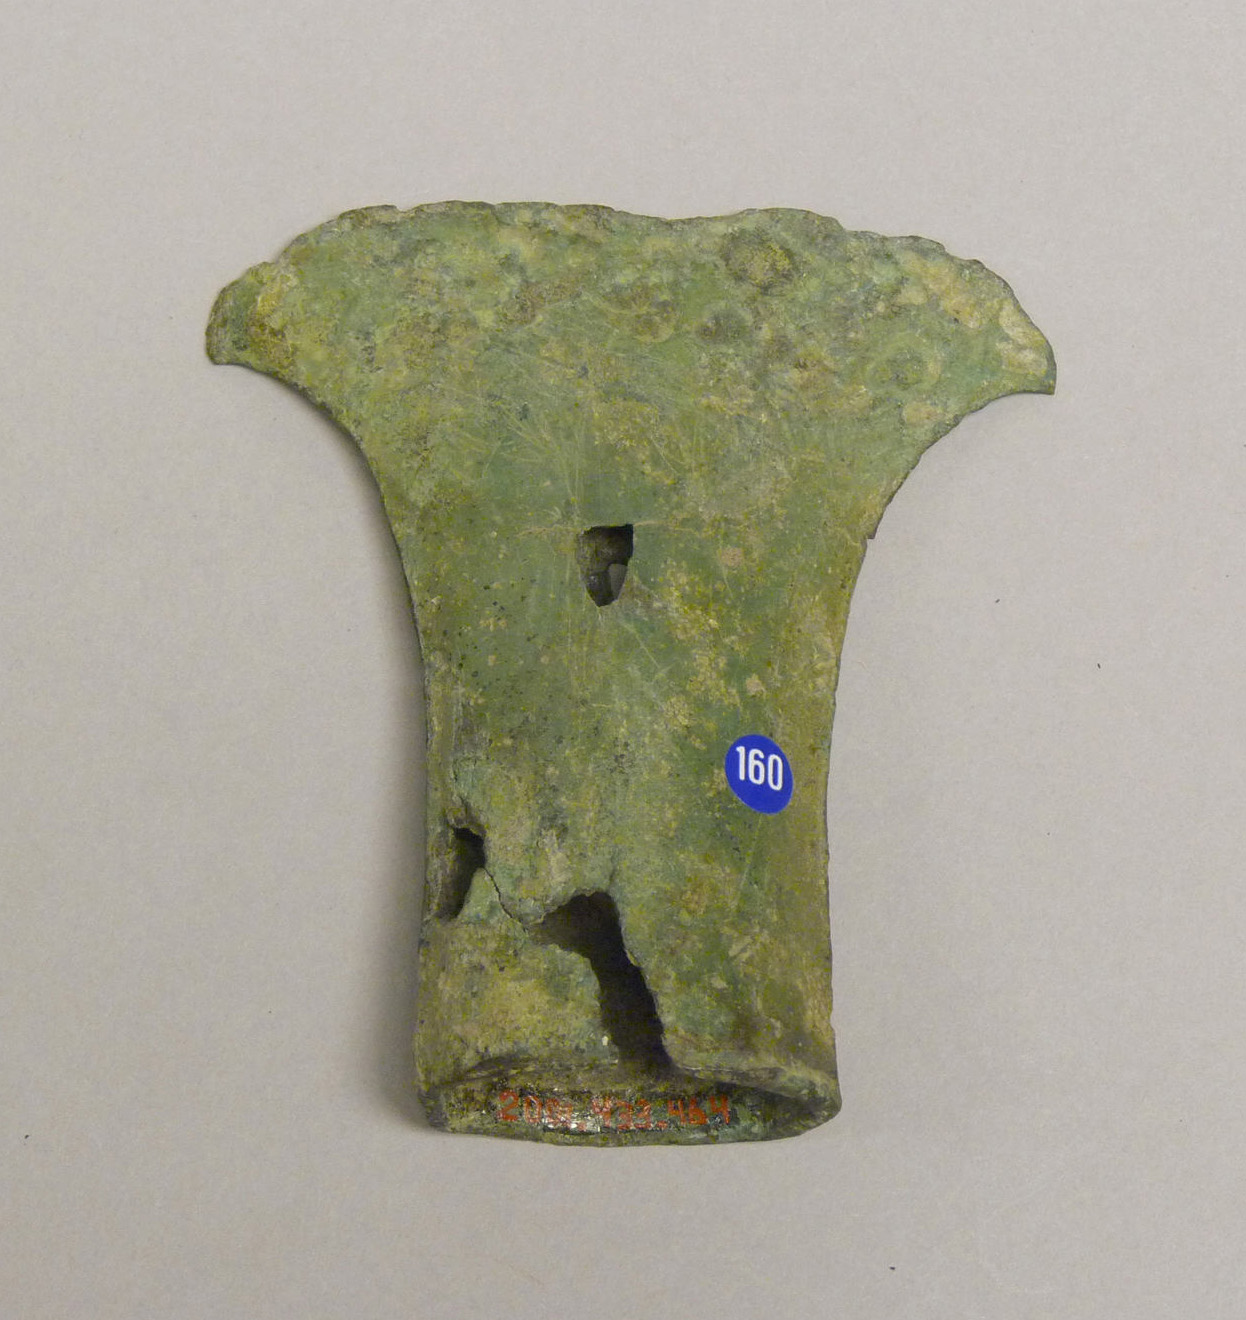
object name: hafted ax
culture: indonesian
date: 500 BCE-300 CE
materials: bronze